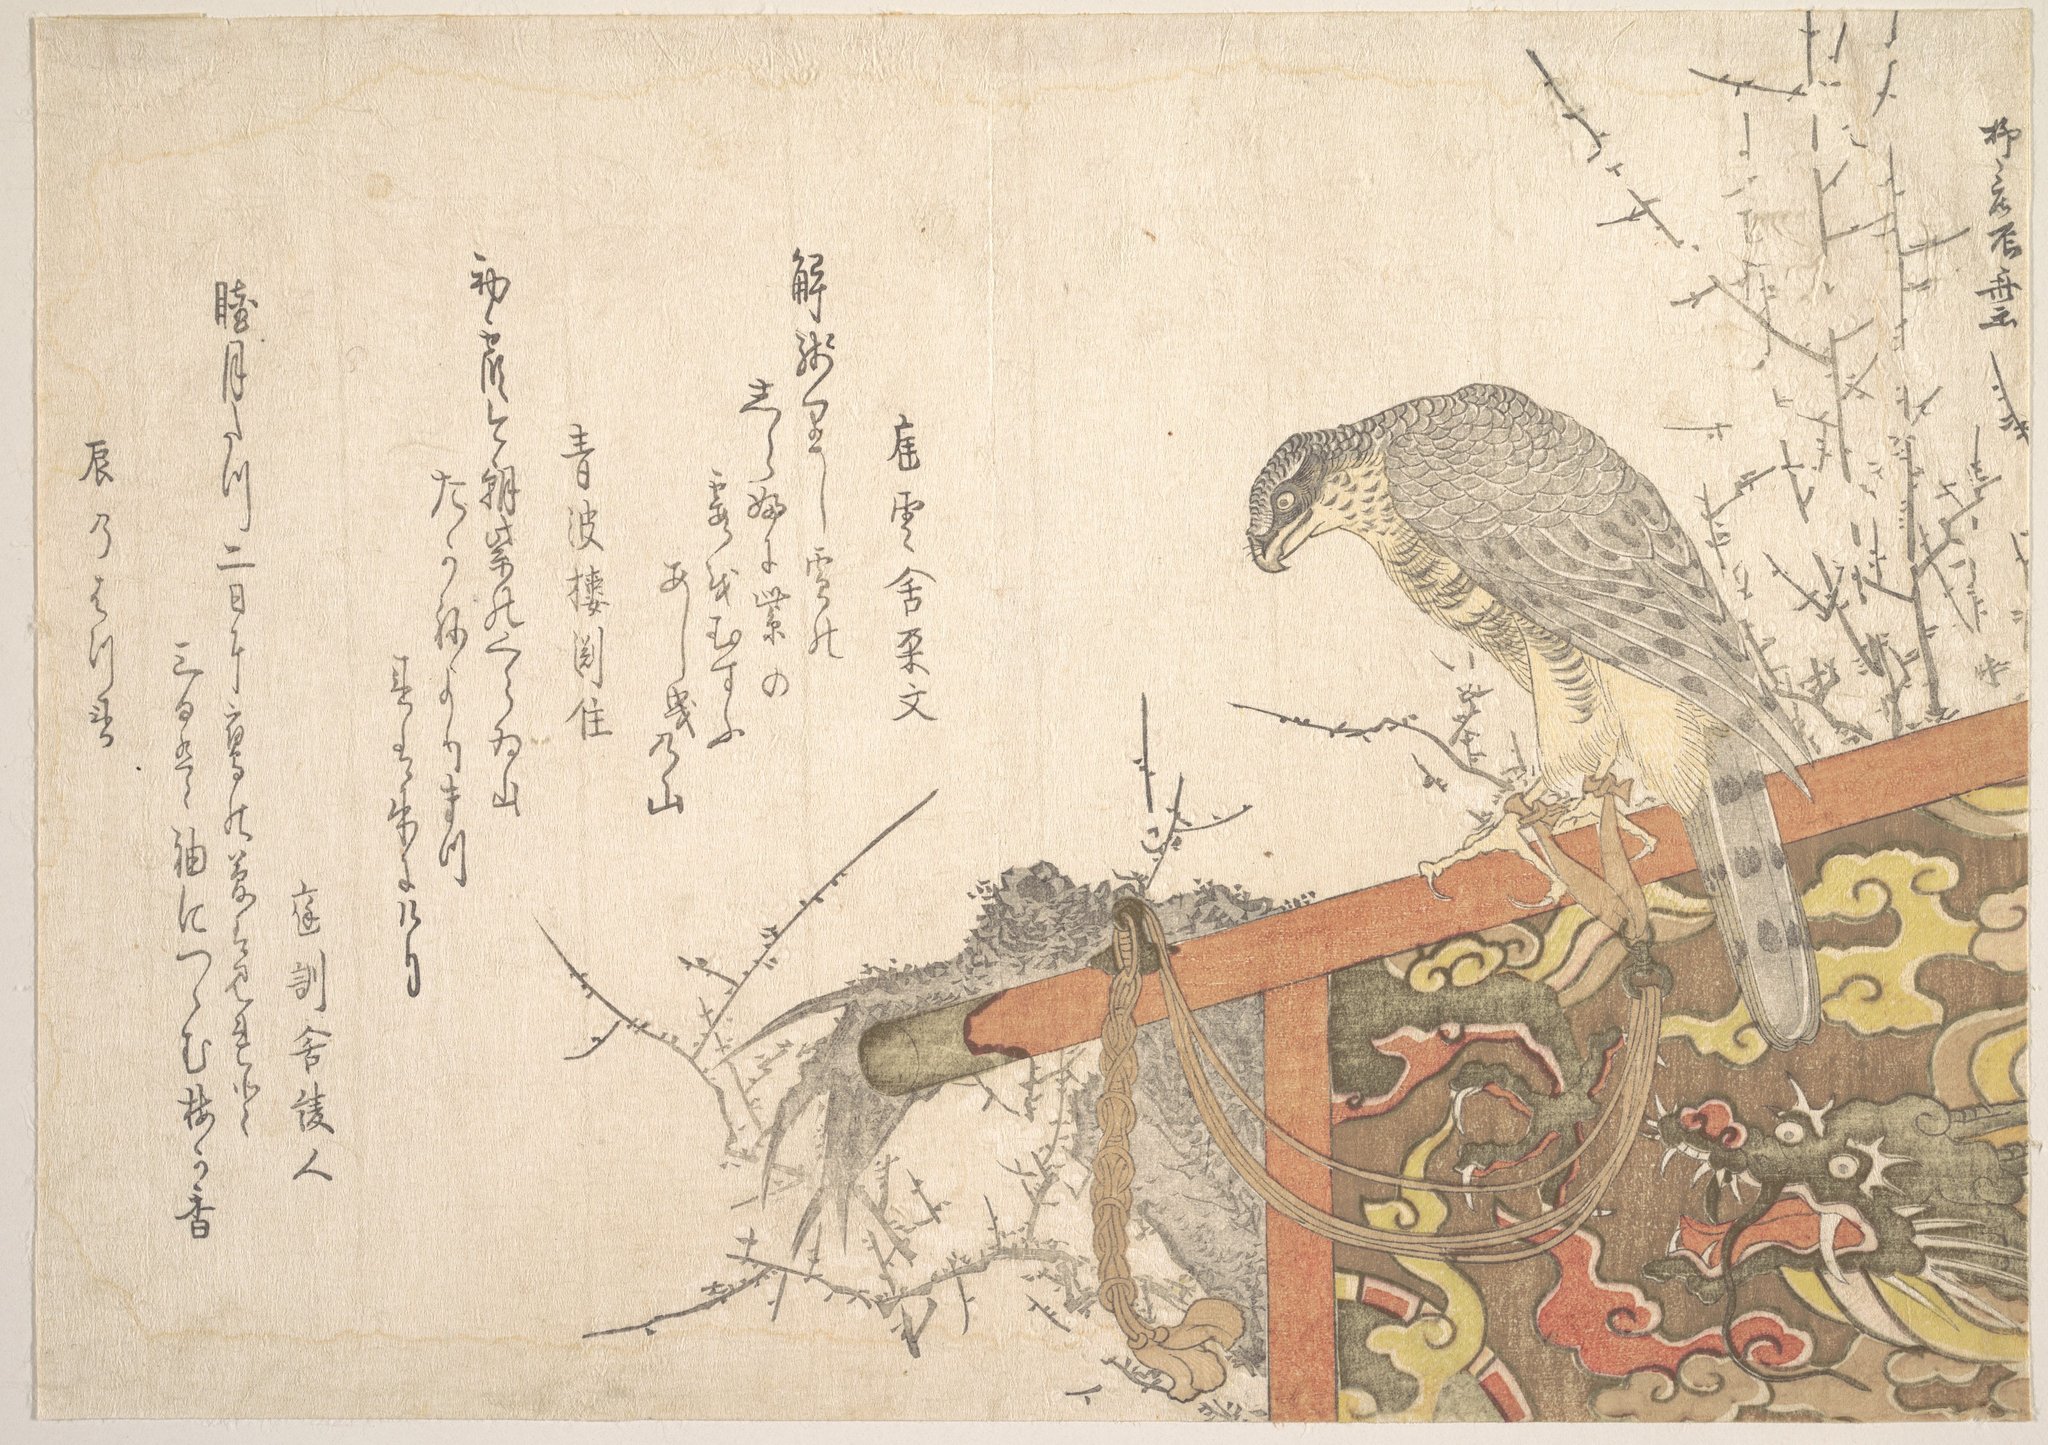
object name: print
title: Hawk Tied to Perch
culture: japanese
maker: ryūryūkyo shinsai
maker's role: artist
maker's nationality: japanese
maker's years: 1799-1823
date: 1750-1835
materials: ink, paper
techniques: surimono, woodblock print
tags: hawks